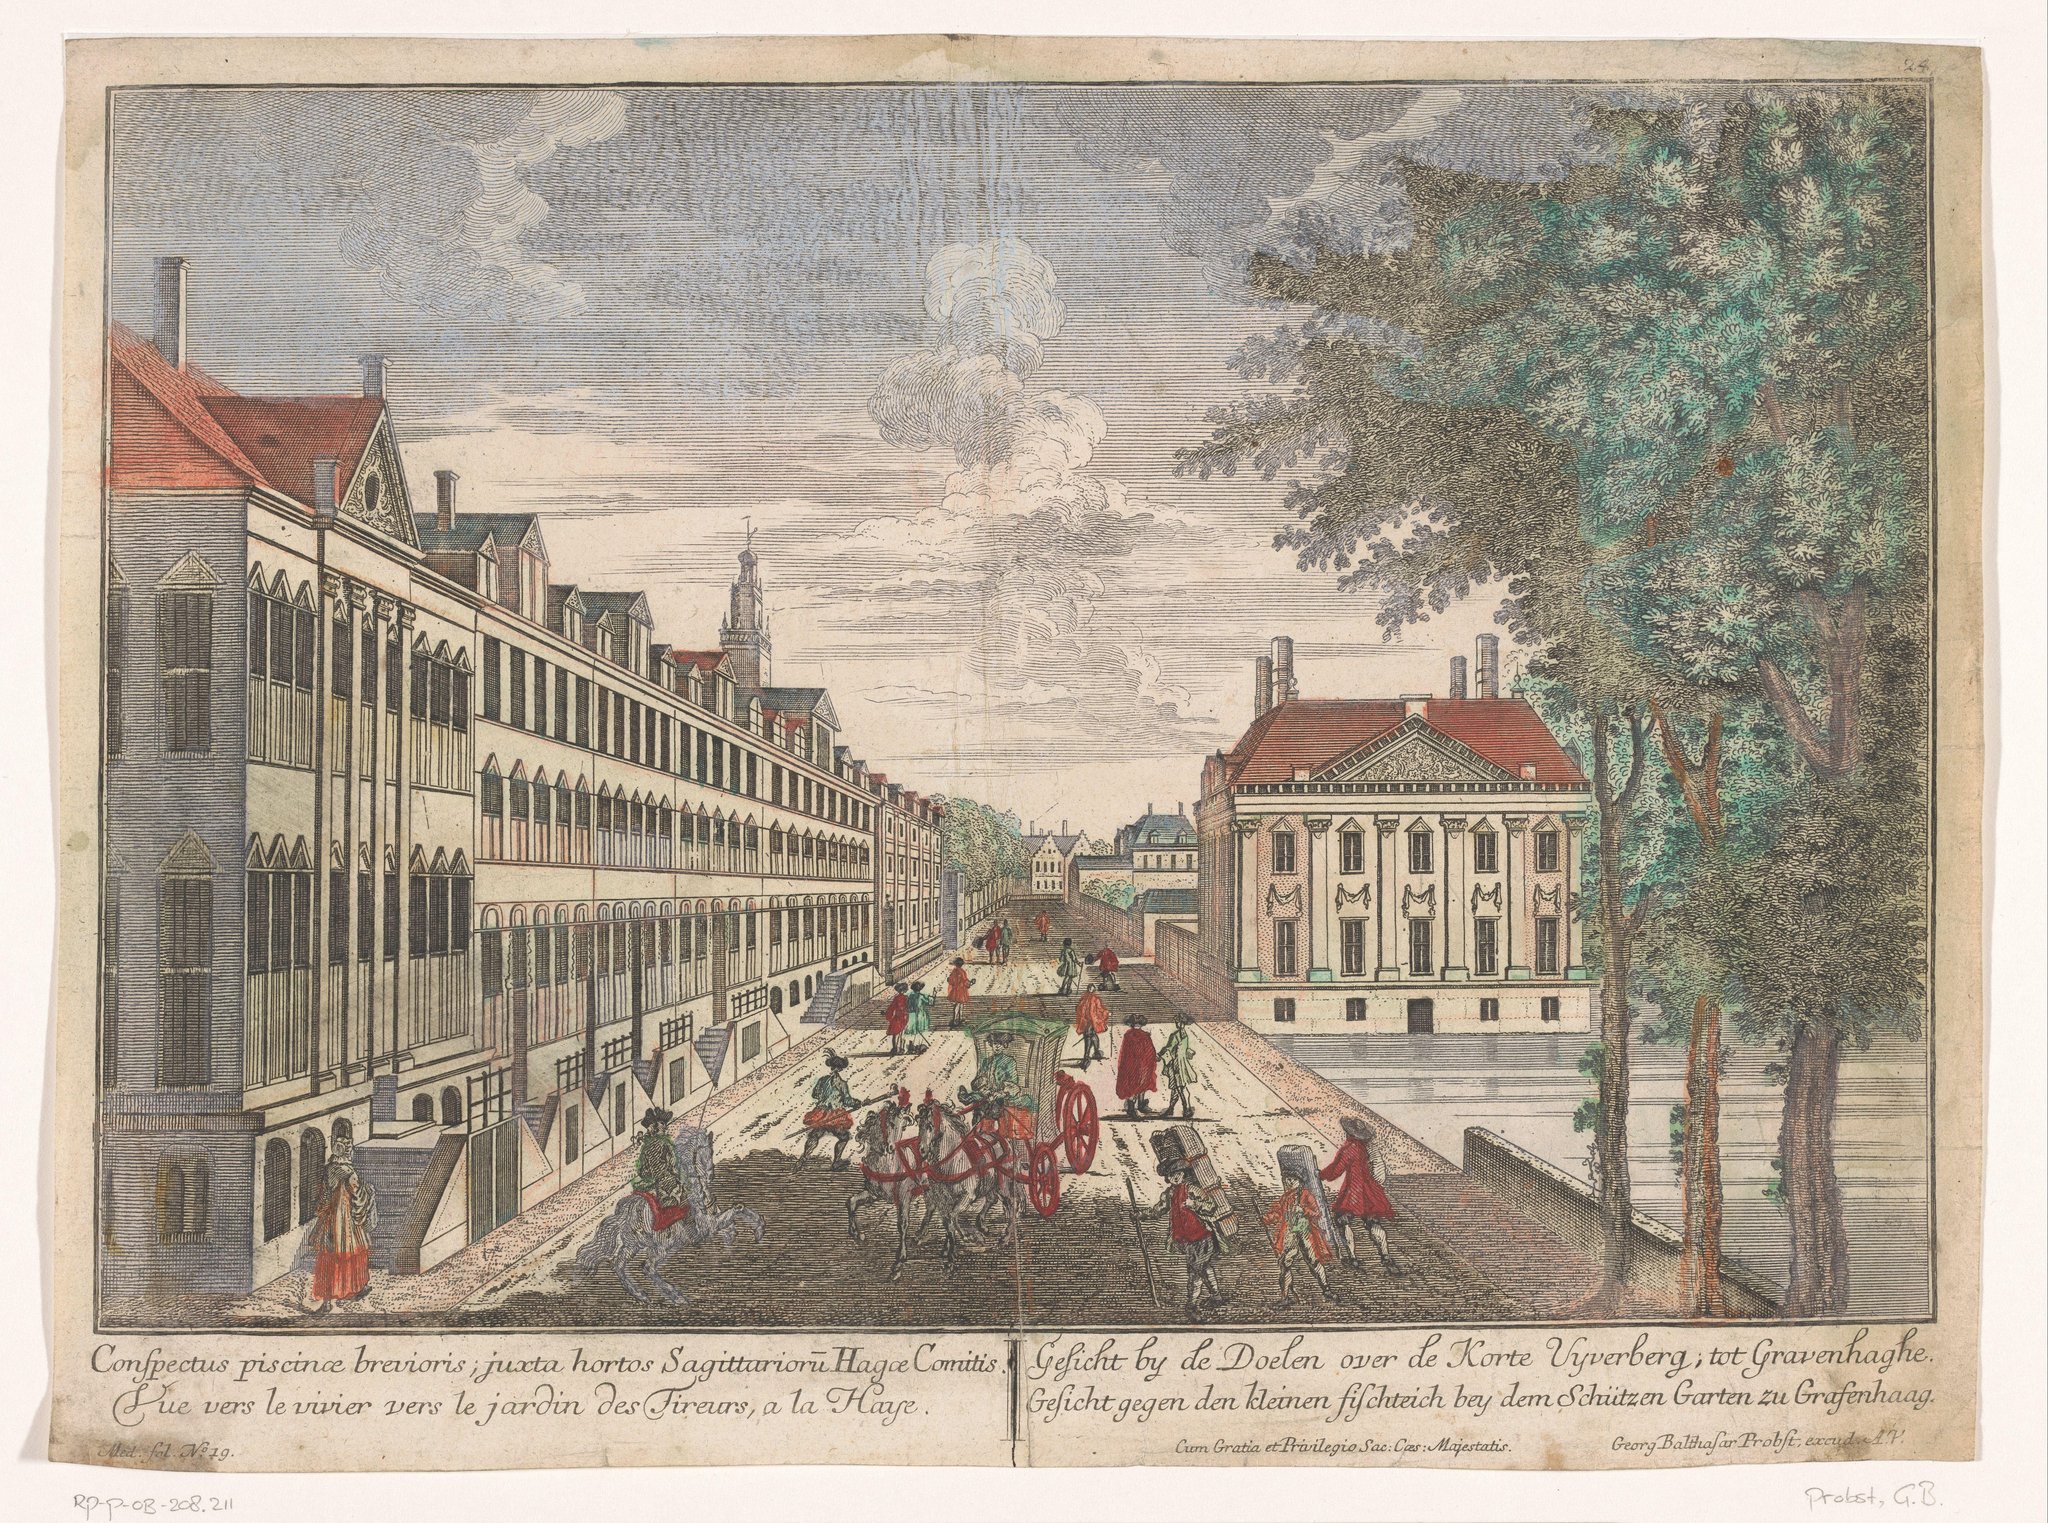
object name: opticaprent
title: Gezicht op het Mauritshuis en de Hofvijver te Den Haag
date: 1742-1801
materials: paper, watercolor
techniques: brush, etching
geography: augsburg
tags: canals, waters (in city) (+ city(-scape) with figures, staffage), street (+ city(-scape) with figures, staffage)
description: De serie “Den Haag”, met het nummer 19, bevat vier prenten met de nummers 21-24, waarvan dit nummer 24 is.